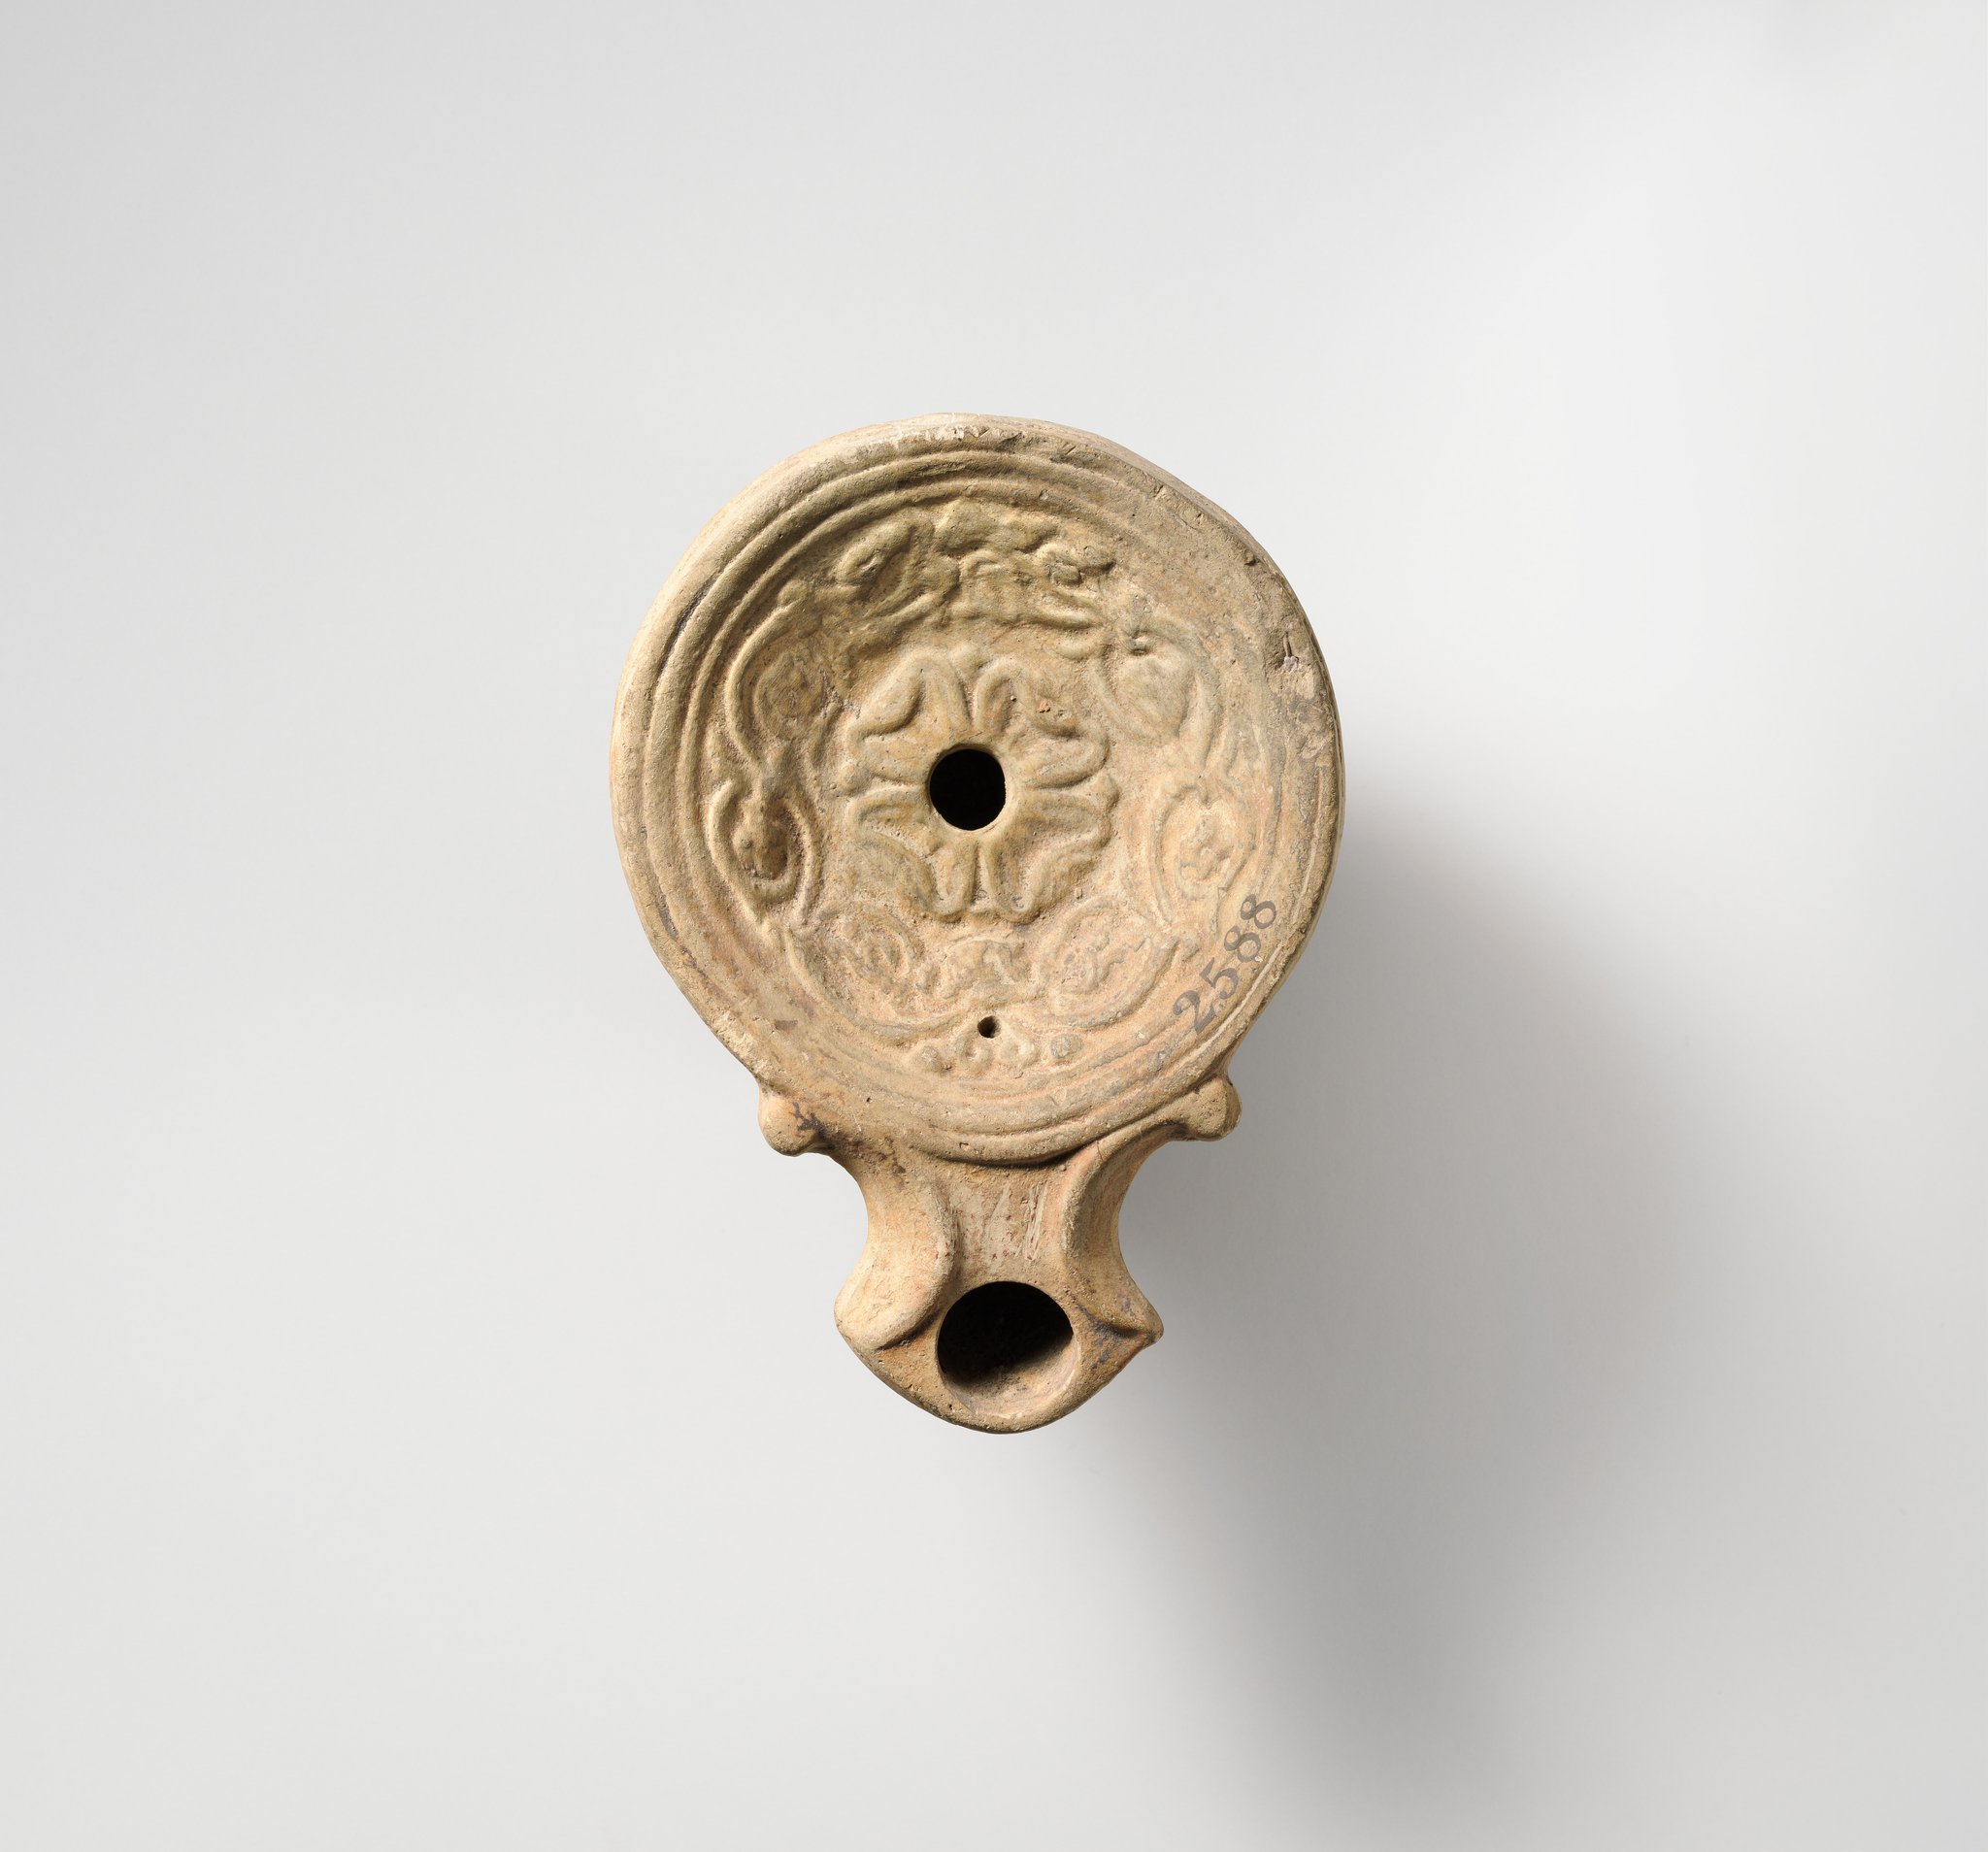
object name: lamp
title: Terracotta oil lamp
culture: roman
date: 100 BCE-100 CE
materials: terracotta